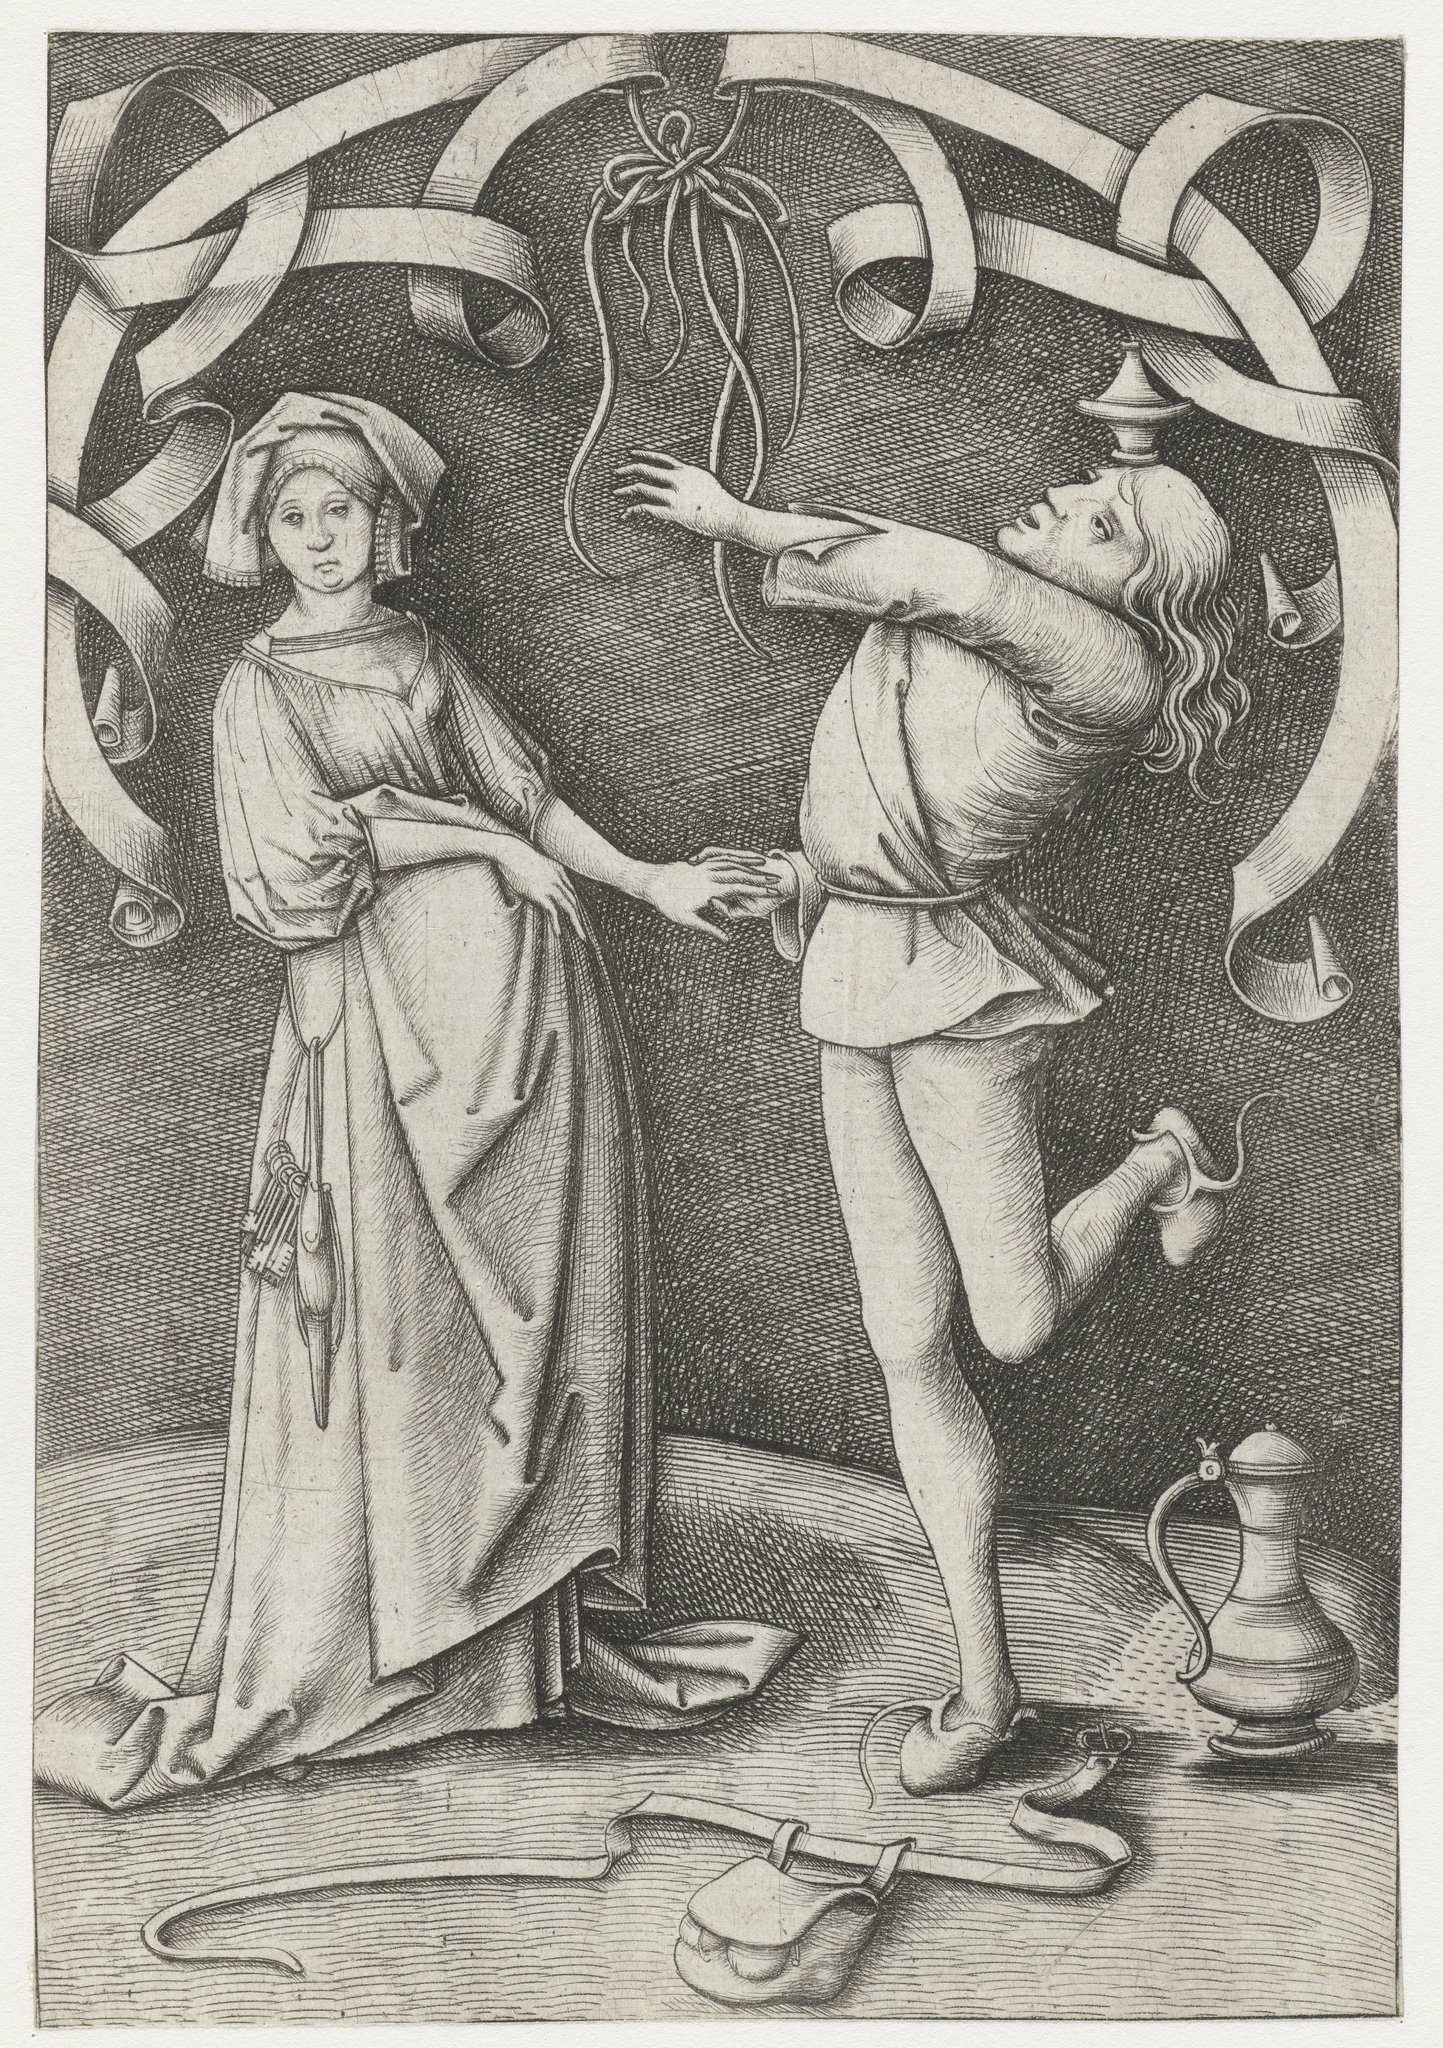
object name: print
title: De jongleur en de vrouw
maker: israhel van meckenem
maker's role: print maker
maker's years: 1440-1517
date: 1475-1503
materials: paper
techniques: engraving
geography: bocholt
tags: belt, girdle, waistband (+ men's clothes), bag (+ men's clothes), other clothing accessories (keys) (+ women's clothes), other clothing accessories (purse) (+ women's clothes), illusionist, conjurer, juggler, 'legerdemain', head-gear: cap (+ women's clothes), dress, gown (+ women's clothes), shoes, sandals (+ men's clothes), trousers, breeches, etc. (breeches) (+ men's clothes), clothing for the upper part of the body (doublet) (+ men's clothes), belt, girdle, waistband (+ women's clothes)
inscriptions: collector's mark: Lugt 240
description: Kleding: vrouw: bovenkleed met wijde mouwen, lage V-vormige halsuitsnijding, bij elkaar gehouden door een vetersluiting. Hoofdbedekking: geplooide hoofddoek over kapje. Accessoires: sleutelbos en beursje (?) aan een ceintuur. Kleding man: lang wambuis met schuin over elkaar sluitende panden en koord om het middel; beenlingen of hosen. Schoenen met ronde neus en een bandje over de wreef. Datering kleding: 1475-1485.